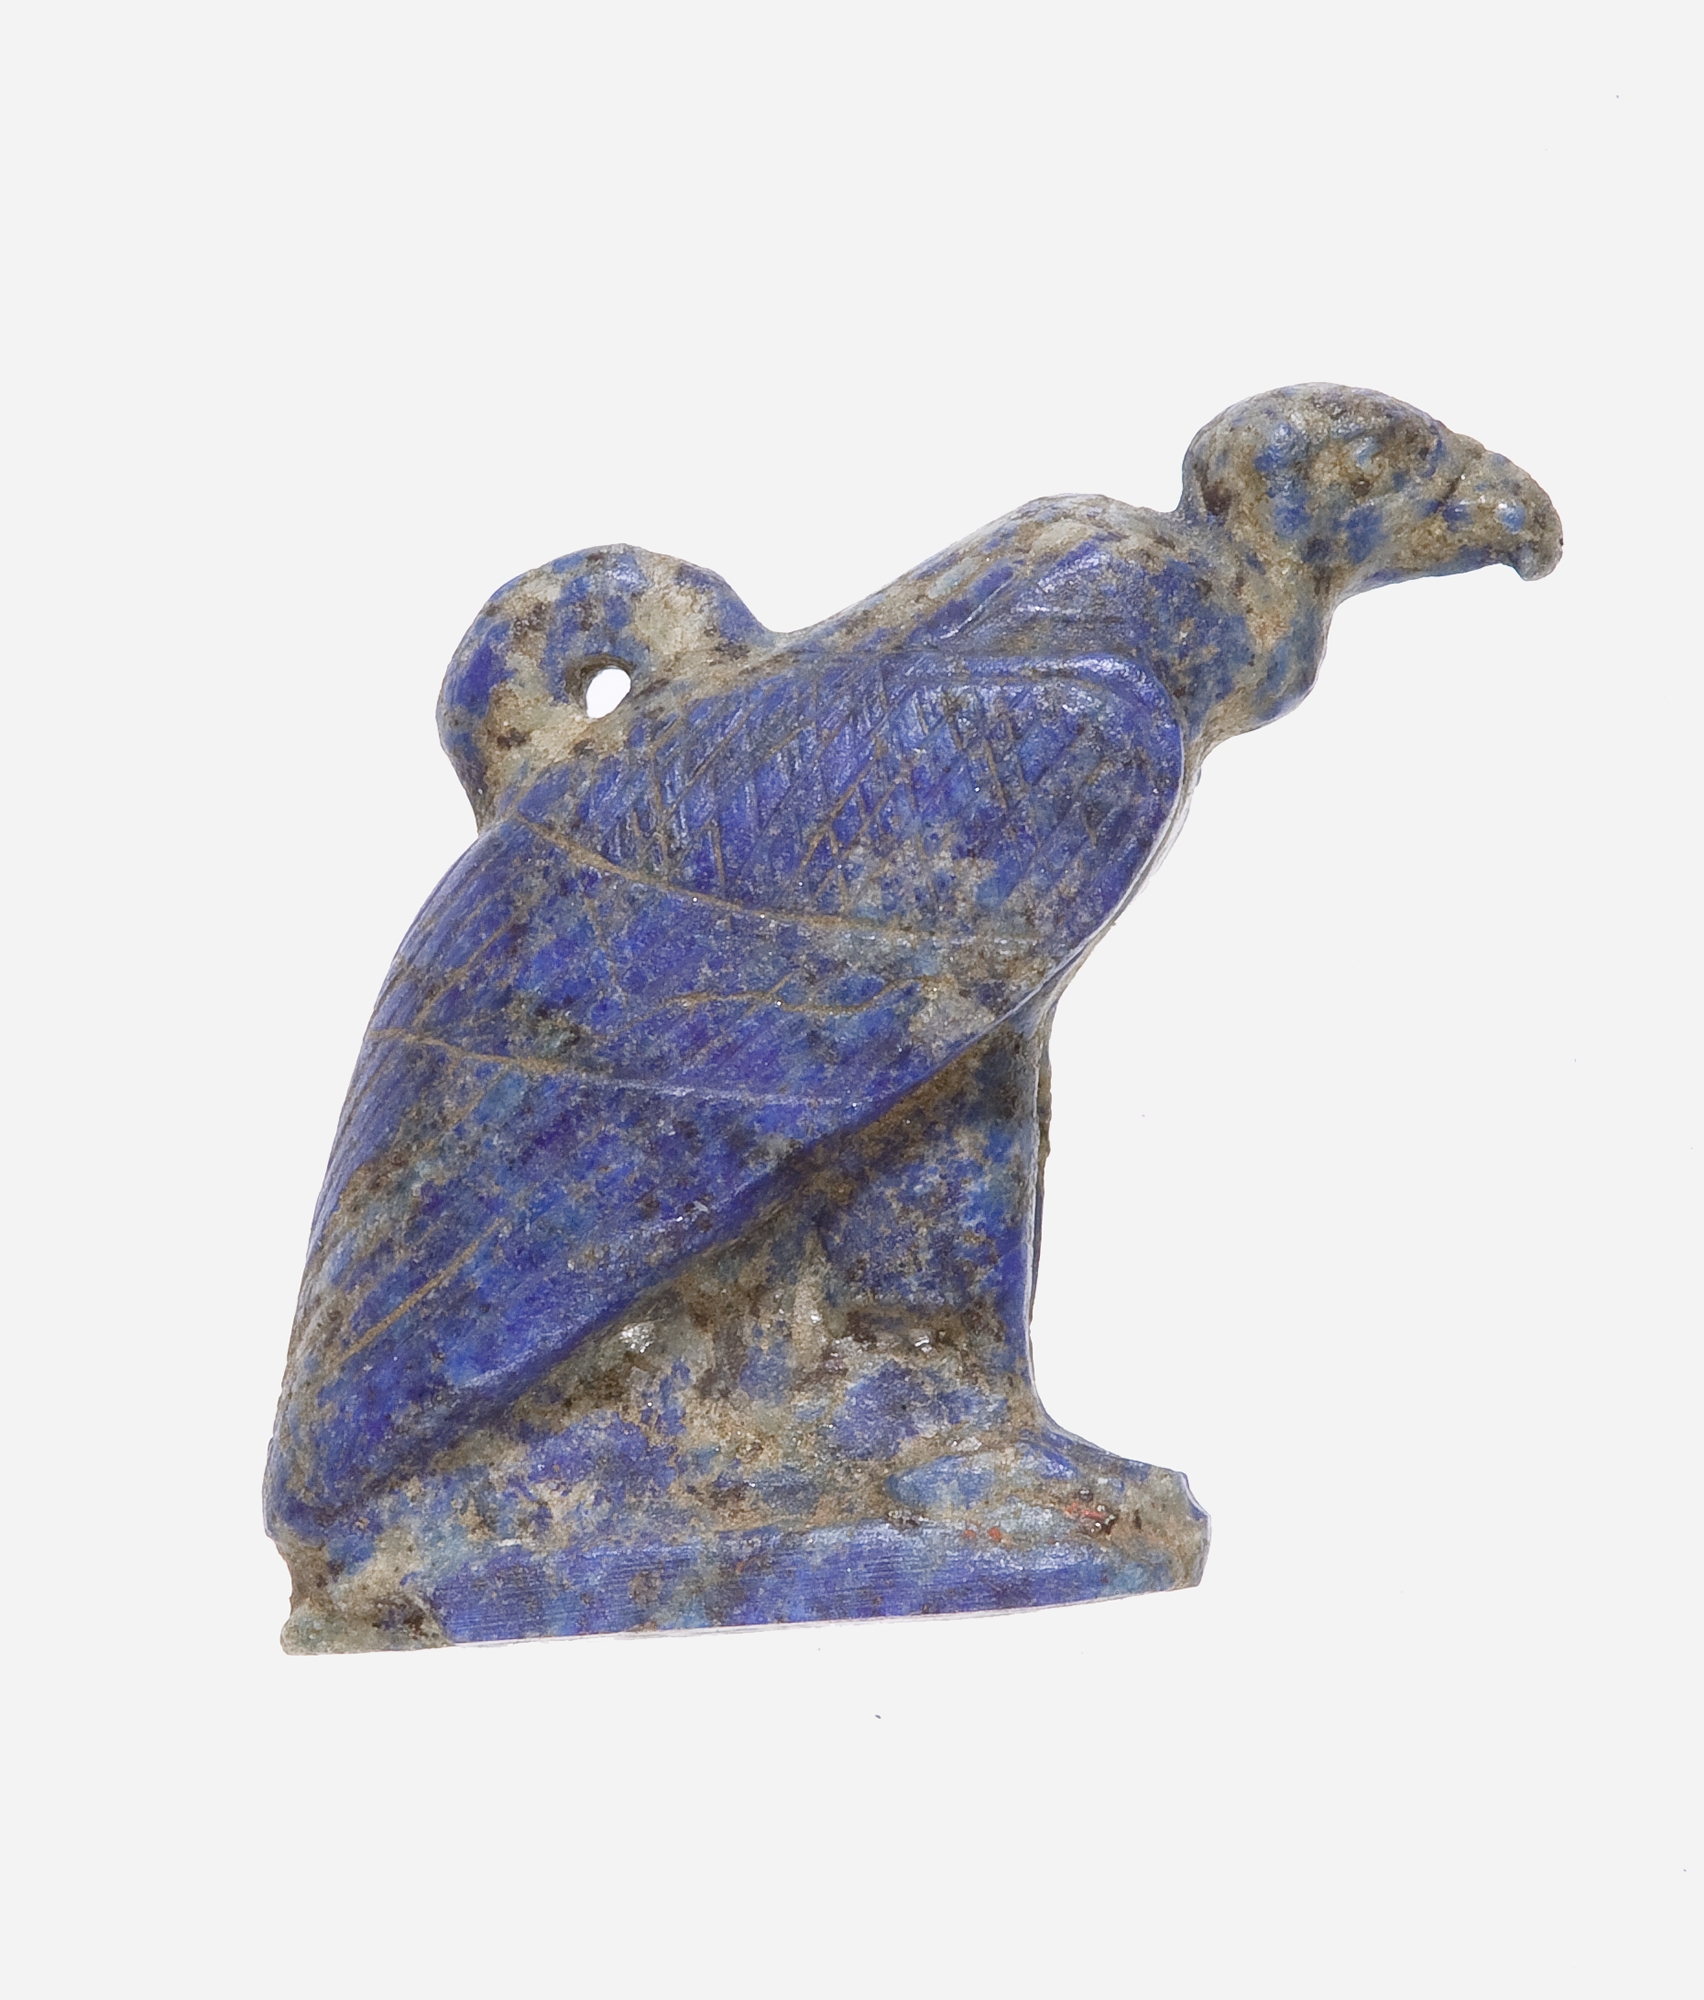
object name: amulet, vulture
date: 664-332 BCE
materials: lapis lazuli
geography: egypt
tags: birds